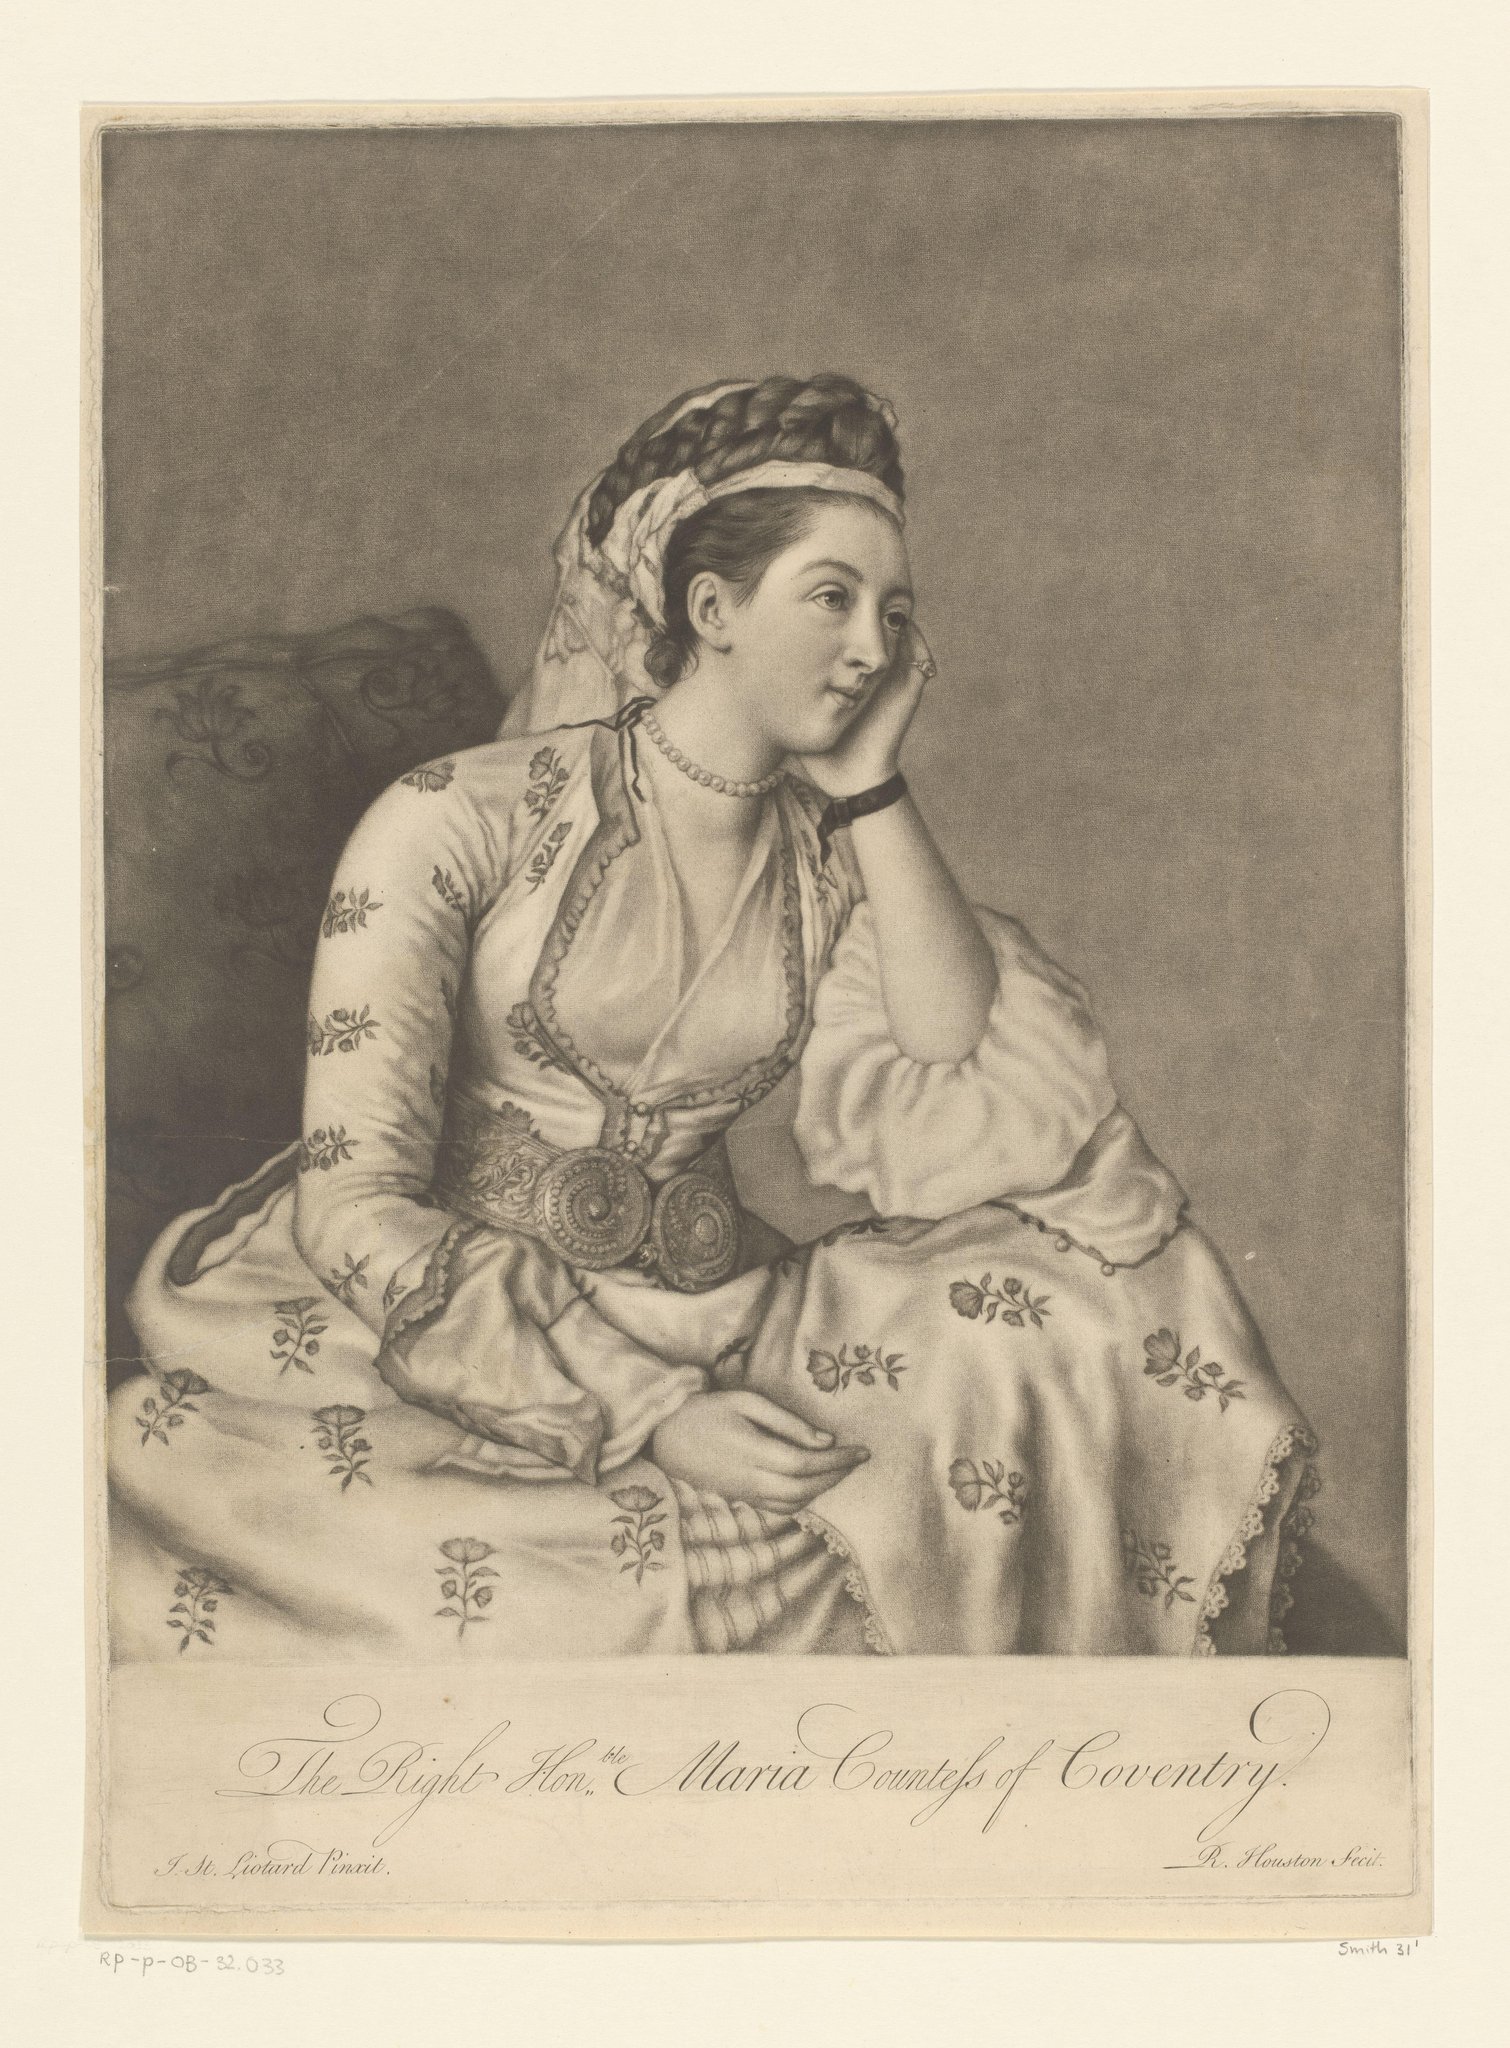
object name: print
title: Portret van Maria Coventry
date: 1745-1775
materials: paper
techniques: mezzotint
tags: historical persons